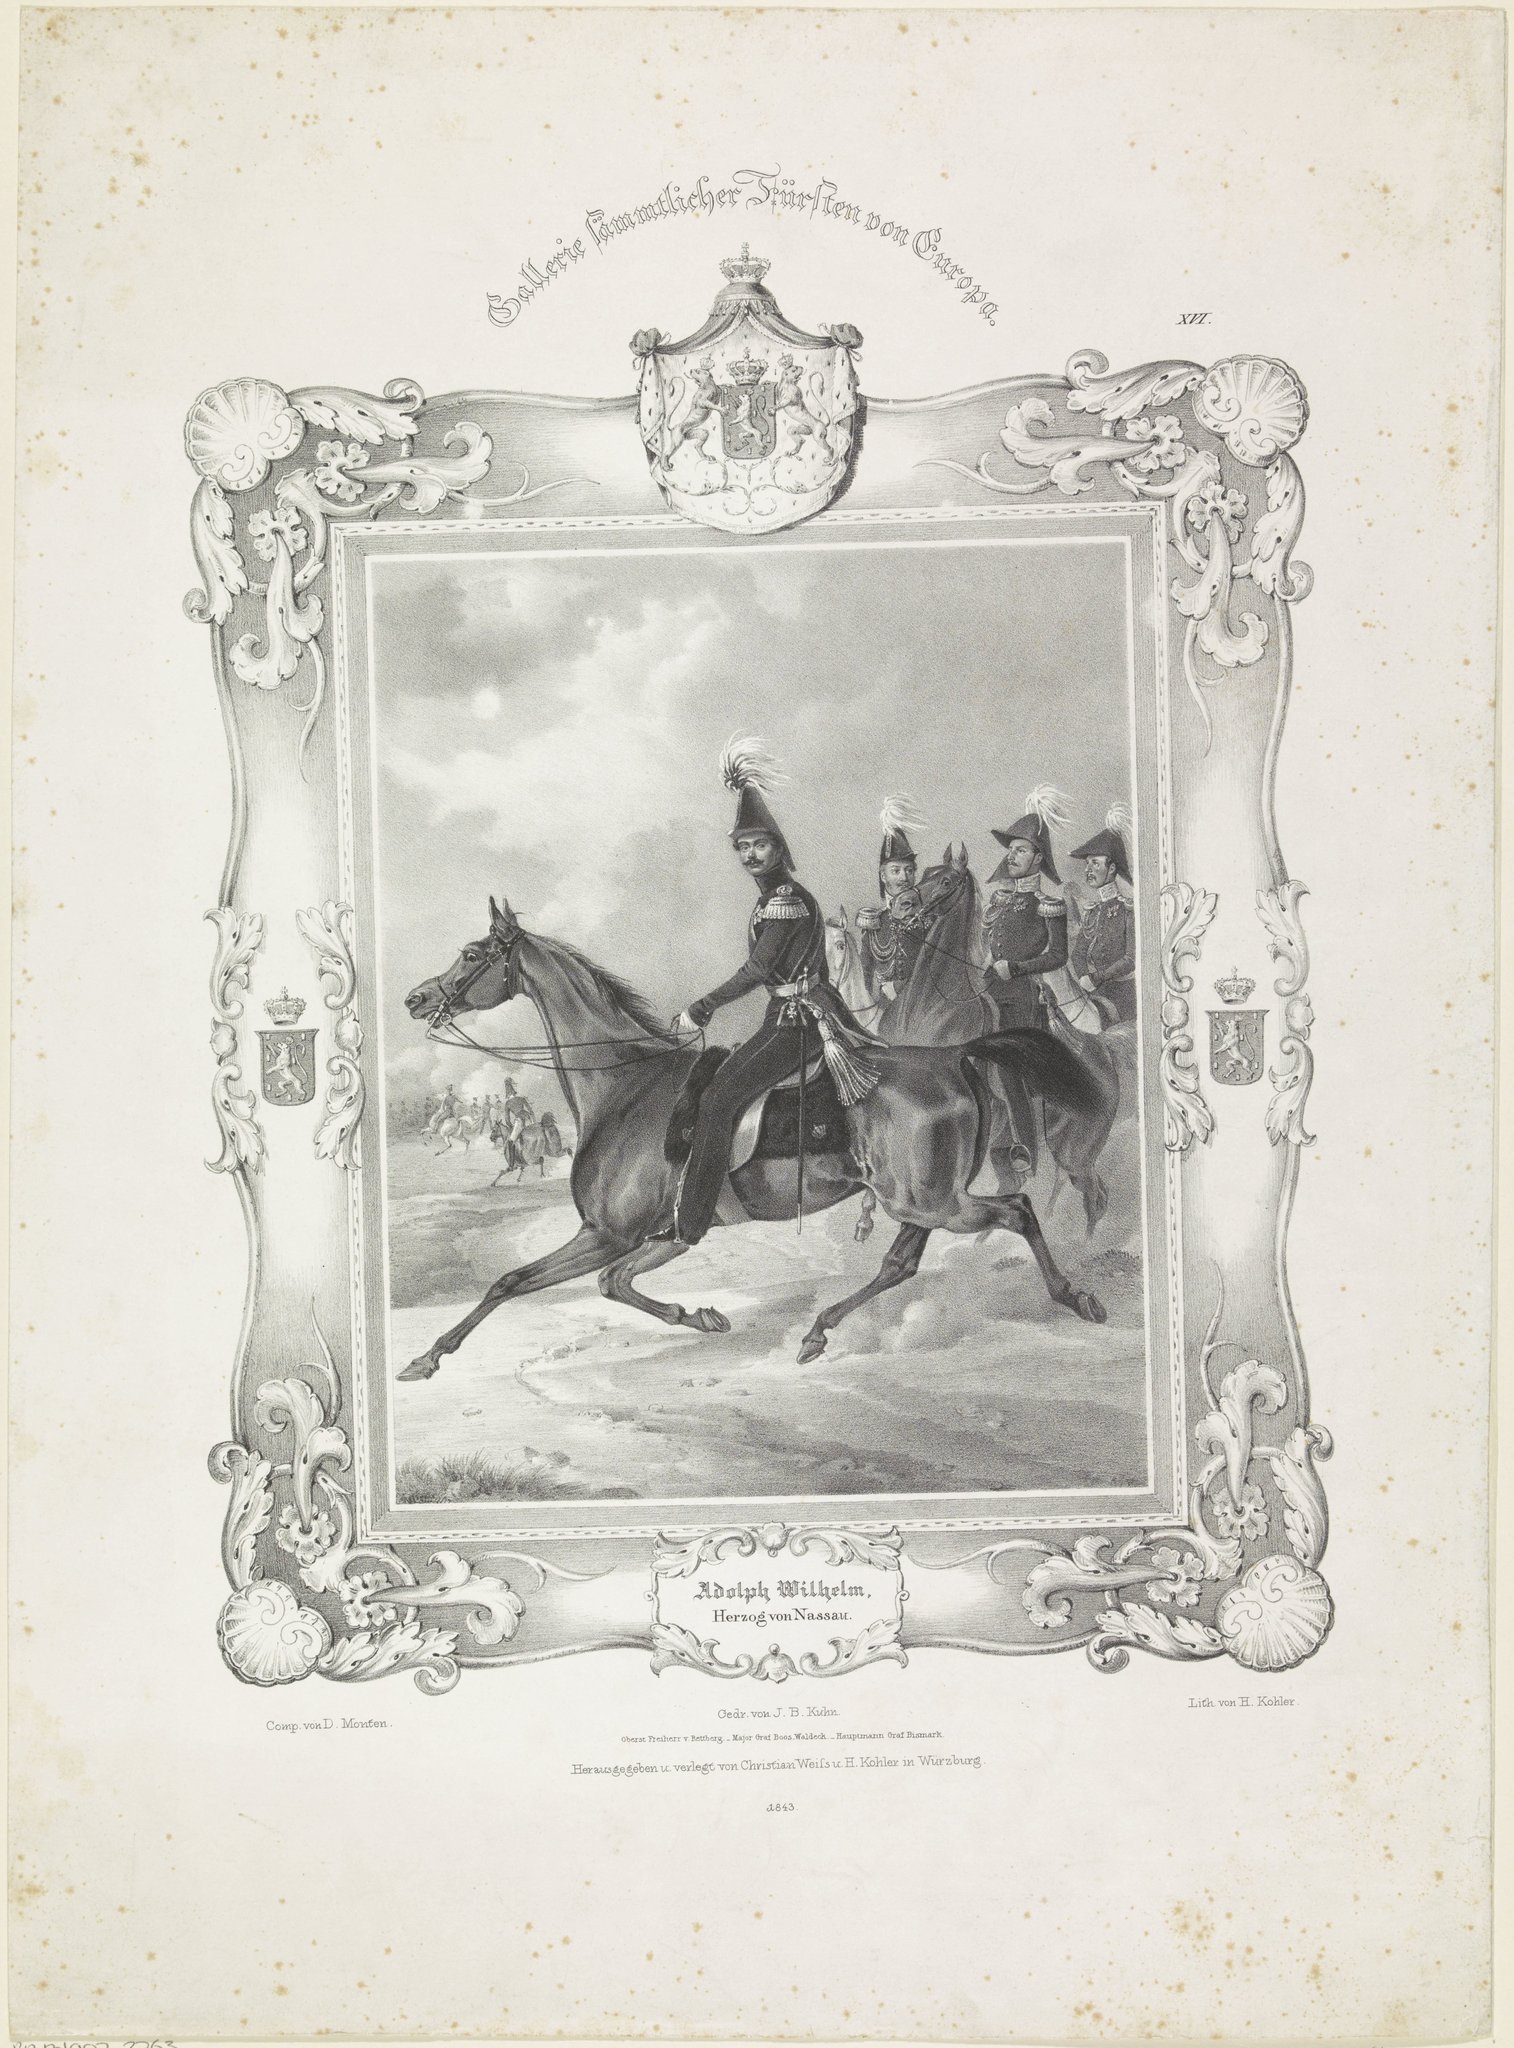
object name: print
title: Ruiterportret van Adolf van Nassau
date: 1843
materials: paper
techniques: lithograph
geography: munich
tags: adolf van nassau, huis nassau walramse linie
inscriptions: collector's mark: Lugt 2228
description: Ruiterportret van Adolf in een geornamenteerde rechthoek. Op de achtergrond ruiters. Midden boven zijn wapen met een kroon en twee leeuwen. In de bovenmarge een regel Duitse tekst. In een cartouche zijn naam en titel.